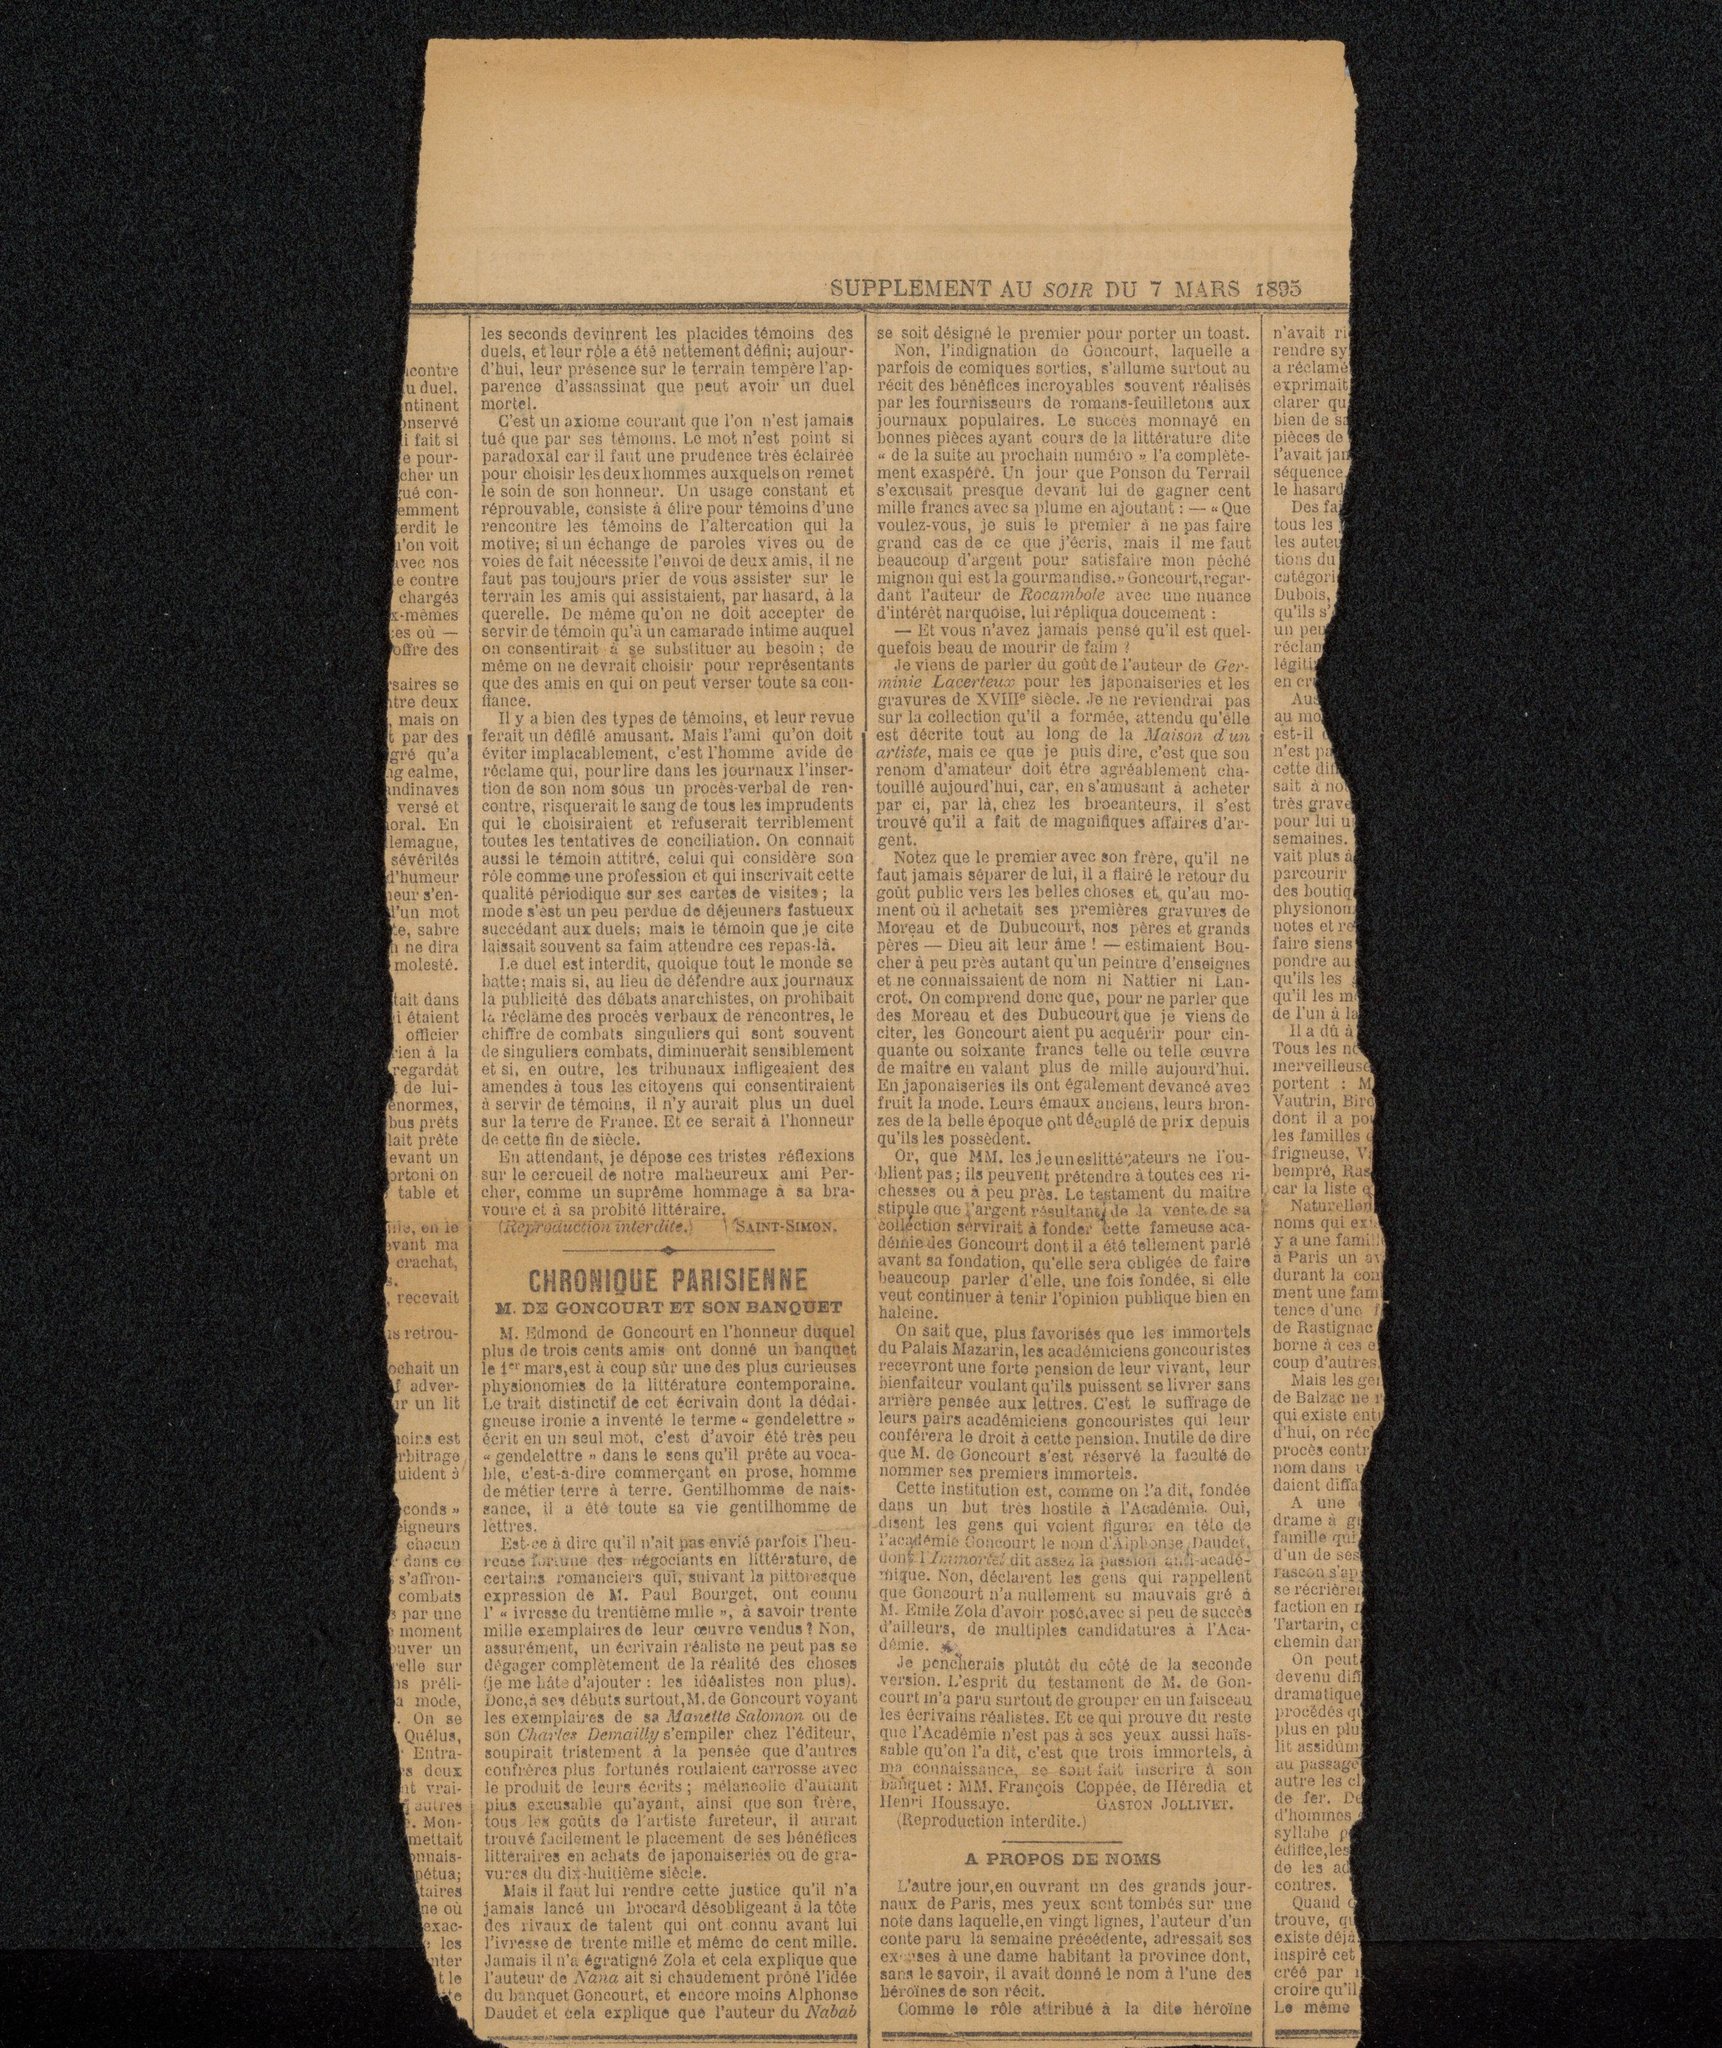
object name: newspaper clipping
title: Krantenknipsel uit archief Philip Zilcken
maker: Anonymous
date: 1895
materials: paper, ink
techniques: printing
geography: france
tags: painter, draughtsman, edmond de goncourt, the hague, philip zilcken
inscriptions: collector's mark: ‘RPK’